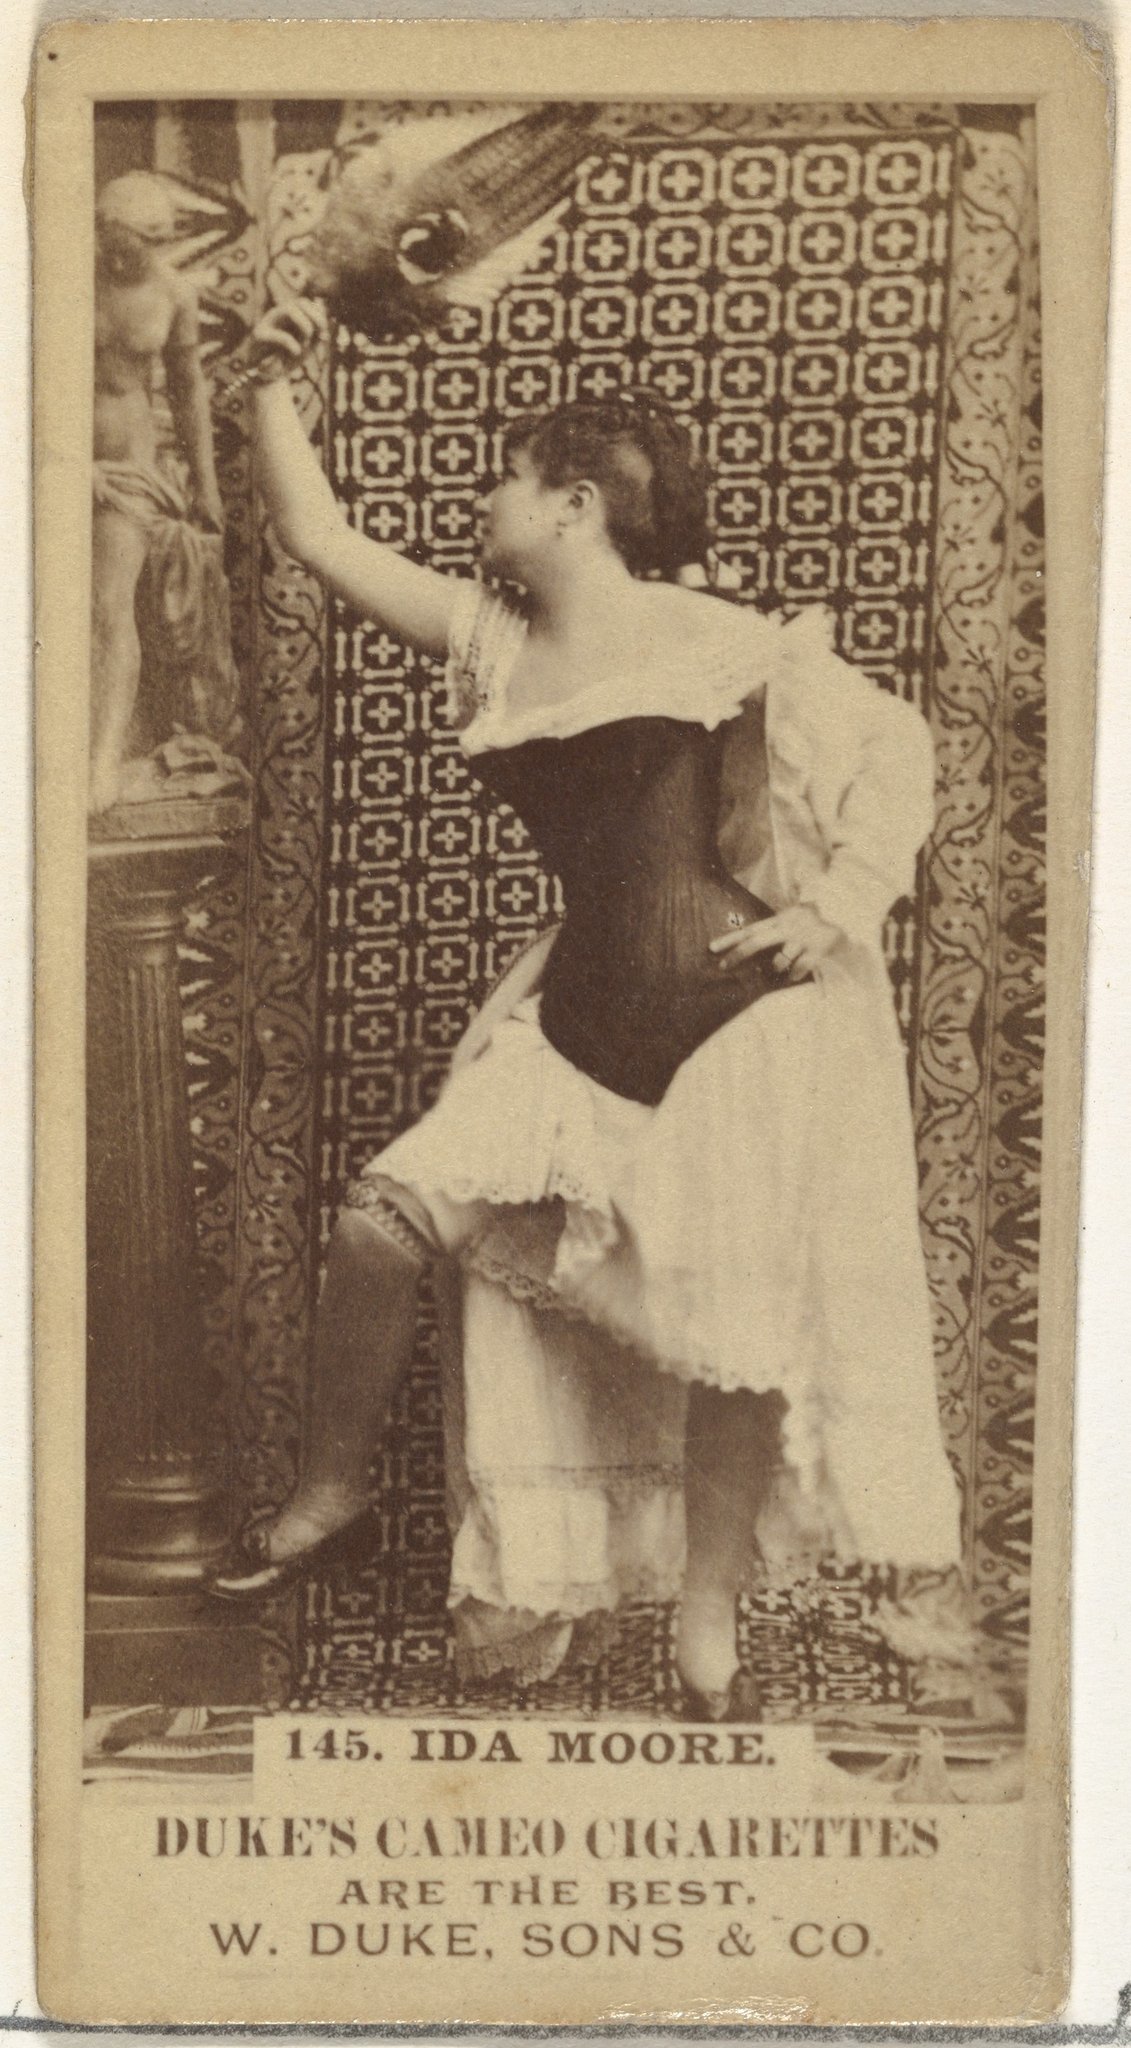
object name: photograph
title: Card Number 145, Ida Moore, from the Actors and Actresses series (N145-5) issued by Duke Sons & Co. to promote Cameo Cigarettes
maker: w. duke, sons & co.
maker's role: publisher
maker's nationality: american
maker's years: 1870-1920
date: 1880-1889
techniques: albumen silver print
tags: women,actresses